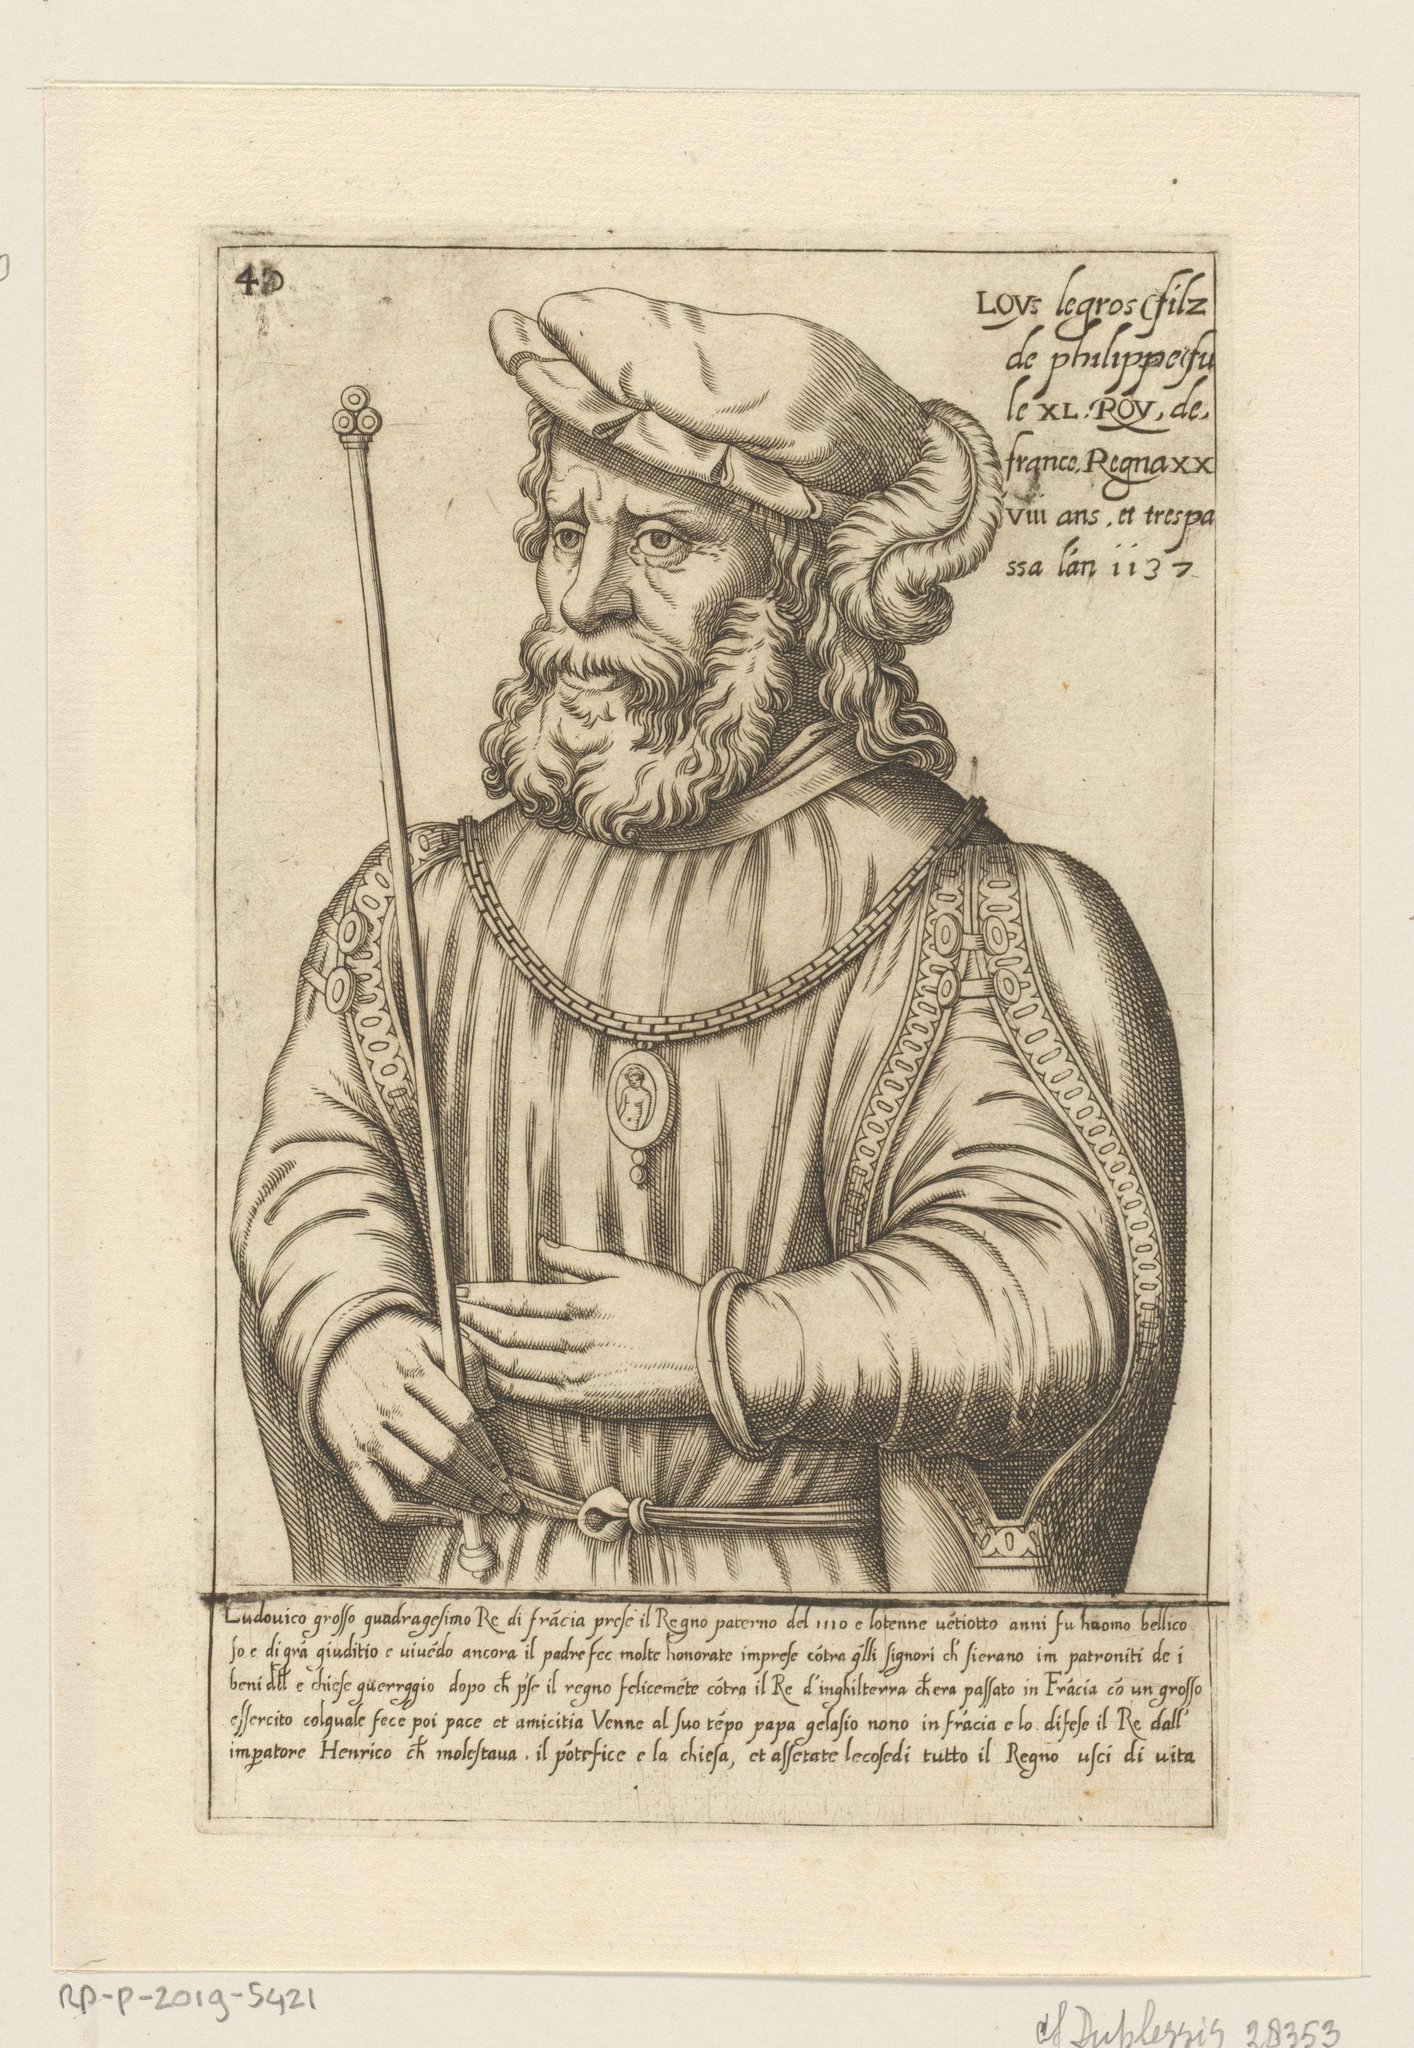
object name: print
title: Portret van Lodewijk VI, koning van Frankrijk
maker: Anonymous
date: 1588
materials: paper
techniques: engraving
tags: paris, sceptre, staff (symbol of sovereignty), historical persons, head-gear: beret, king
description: Prent voor het eerst gebruikt in: Cronica Breve de i fatti illustri de're di Francia, con le loro effigie dal naturale cominciando da Faramondo (...). Venetië: Bernardo Giunti, 1588. Prent in ieder geval ook gebruikt in de editie van 1590 en mogelijk ook in een Franse uitgave van 1597.